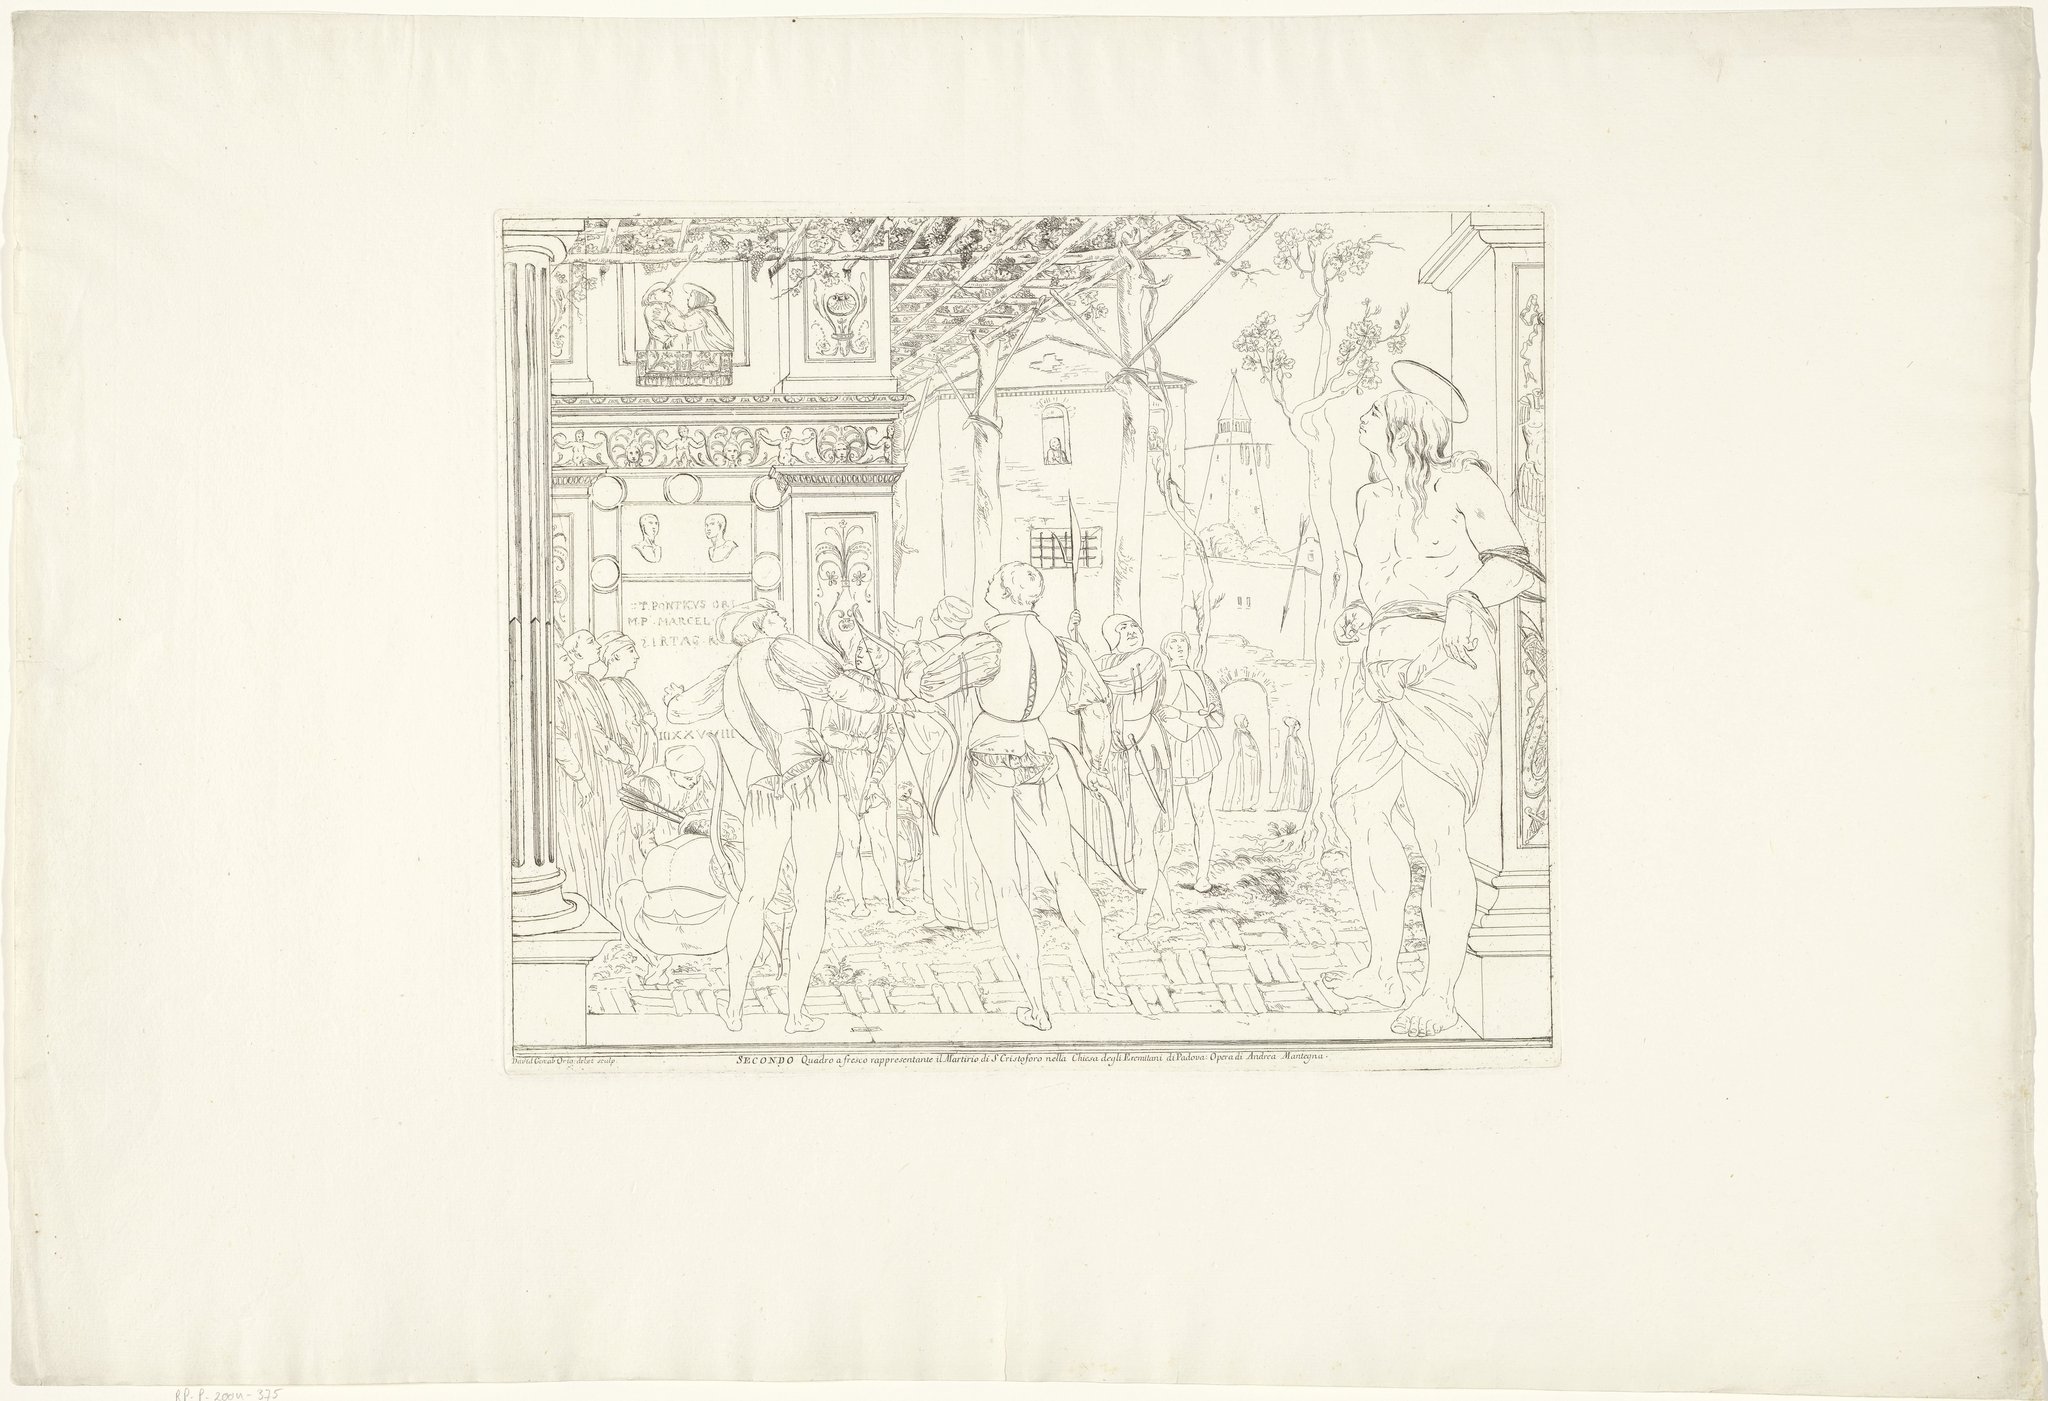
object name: print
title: Martelaarschap van de heilige Christoffel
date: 1776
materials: paper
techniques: etching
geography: italy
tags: forty archers fail to harm st. christopher, the arrows being miraculously deflected; one of the arrows returns and strikes the king in the eye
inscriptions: collector's mark: Lugt 2228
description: De heilige Christoffel staat vastgebonden aan een pilaar. Voor hem staat een groep soldaten die omhoog kijken naar een venster waar de koning van Lycië zojuist in zijn oog is geschoten met een pijl die voor Christoffel bedoeld was.